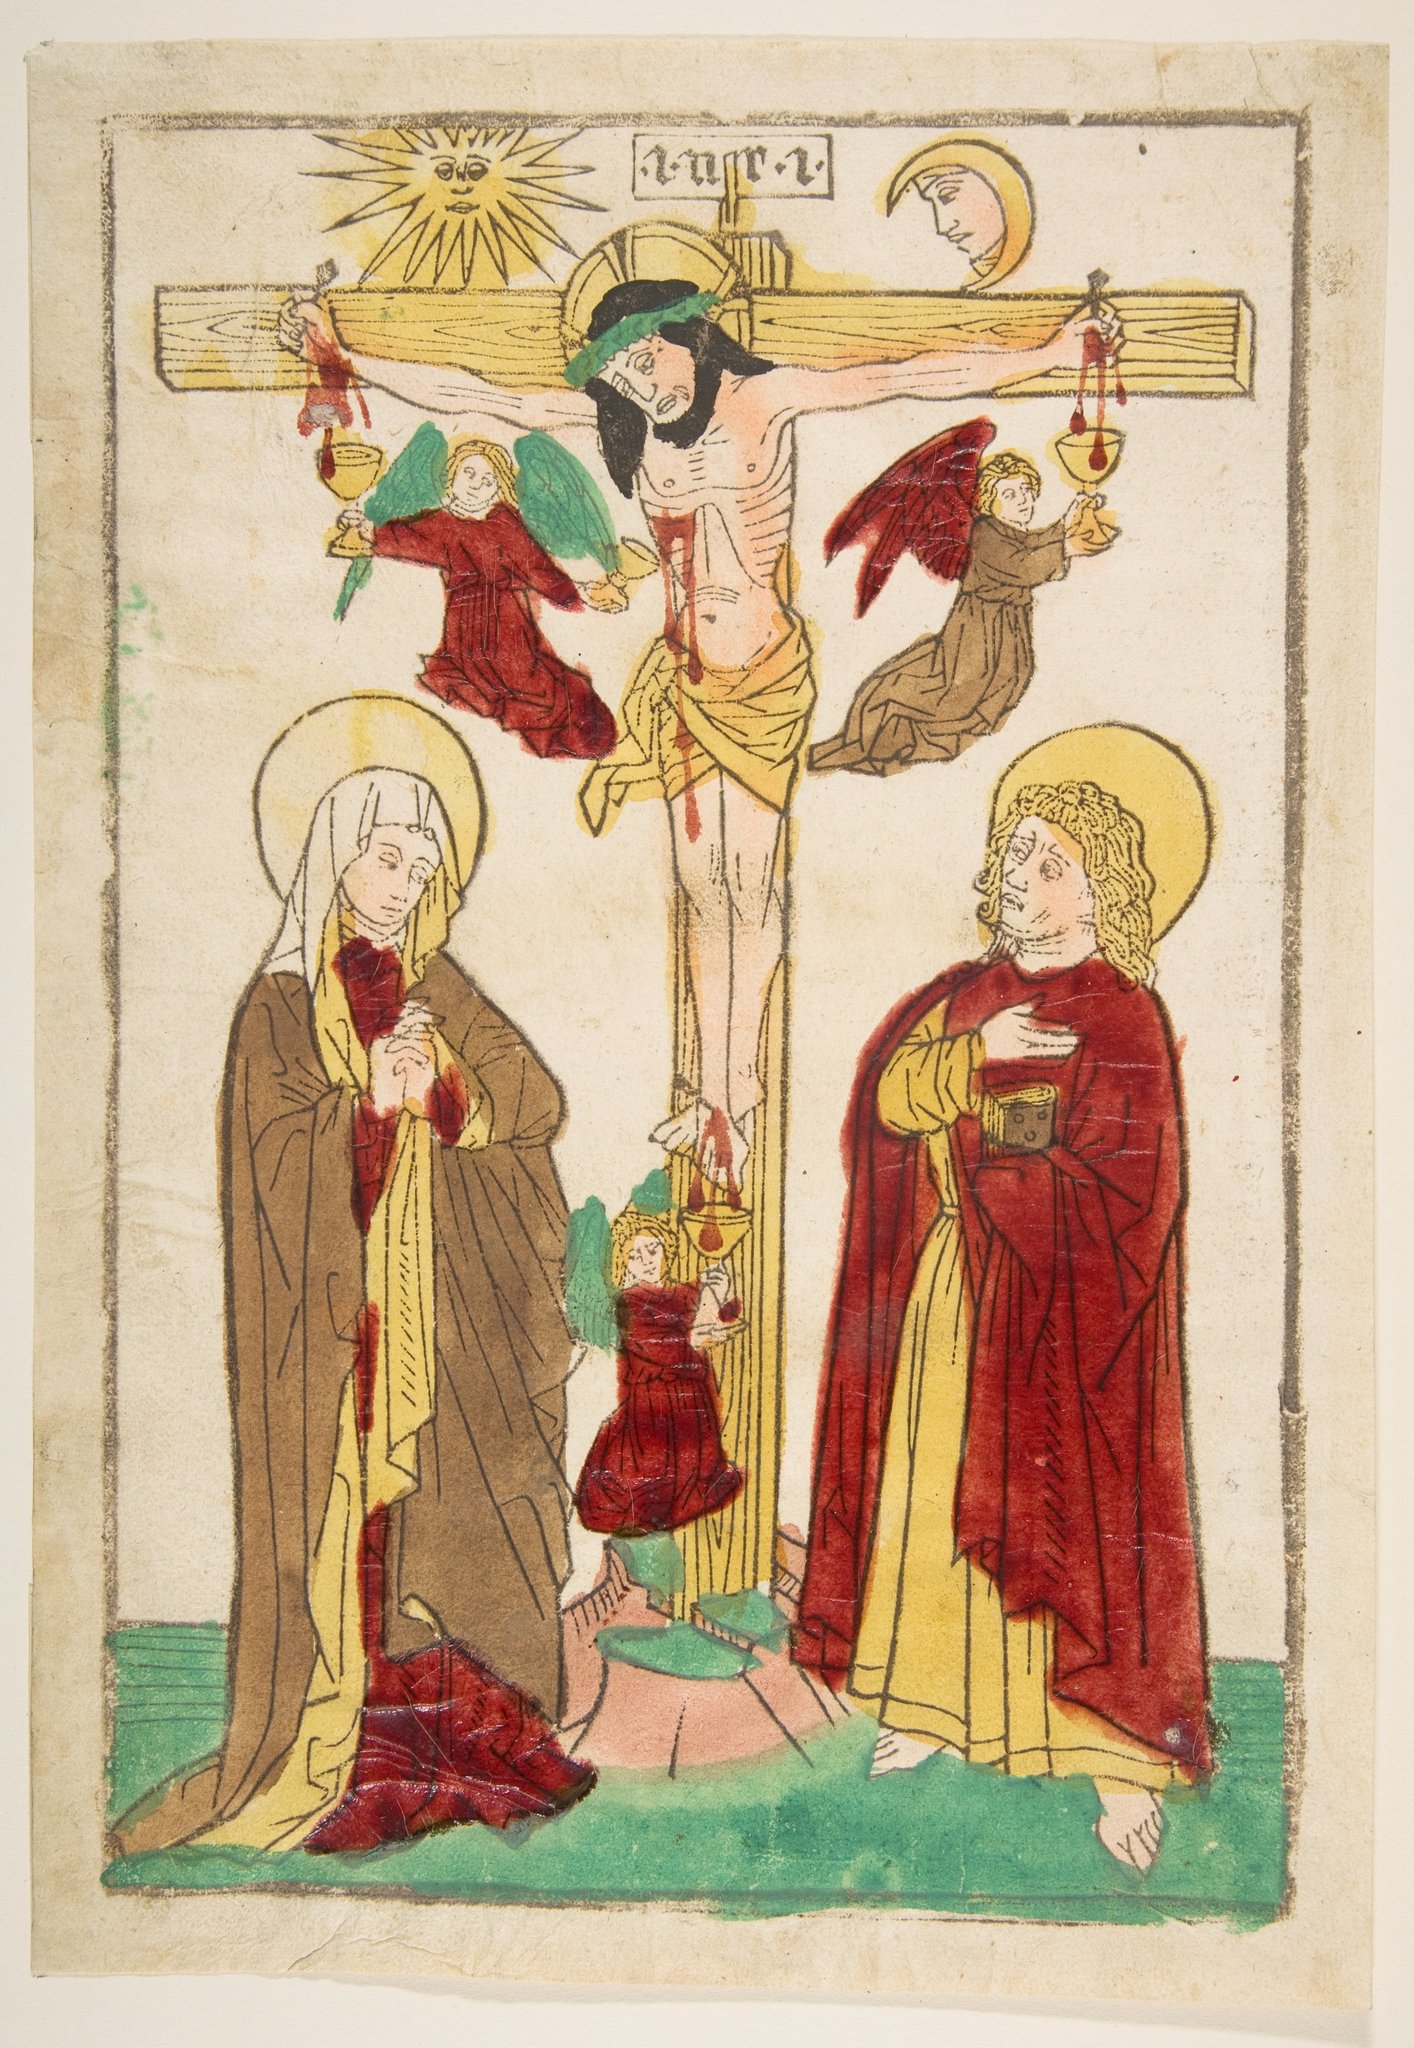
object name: print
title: Christ on the Cross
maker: anonymous, german, 15th century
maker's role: artist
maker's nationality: german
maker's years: 1400-1500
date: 1401-1500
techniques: hand coloring, woodcut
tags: angels,christ,virgin mary,crucifixion,saints